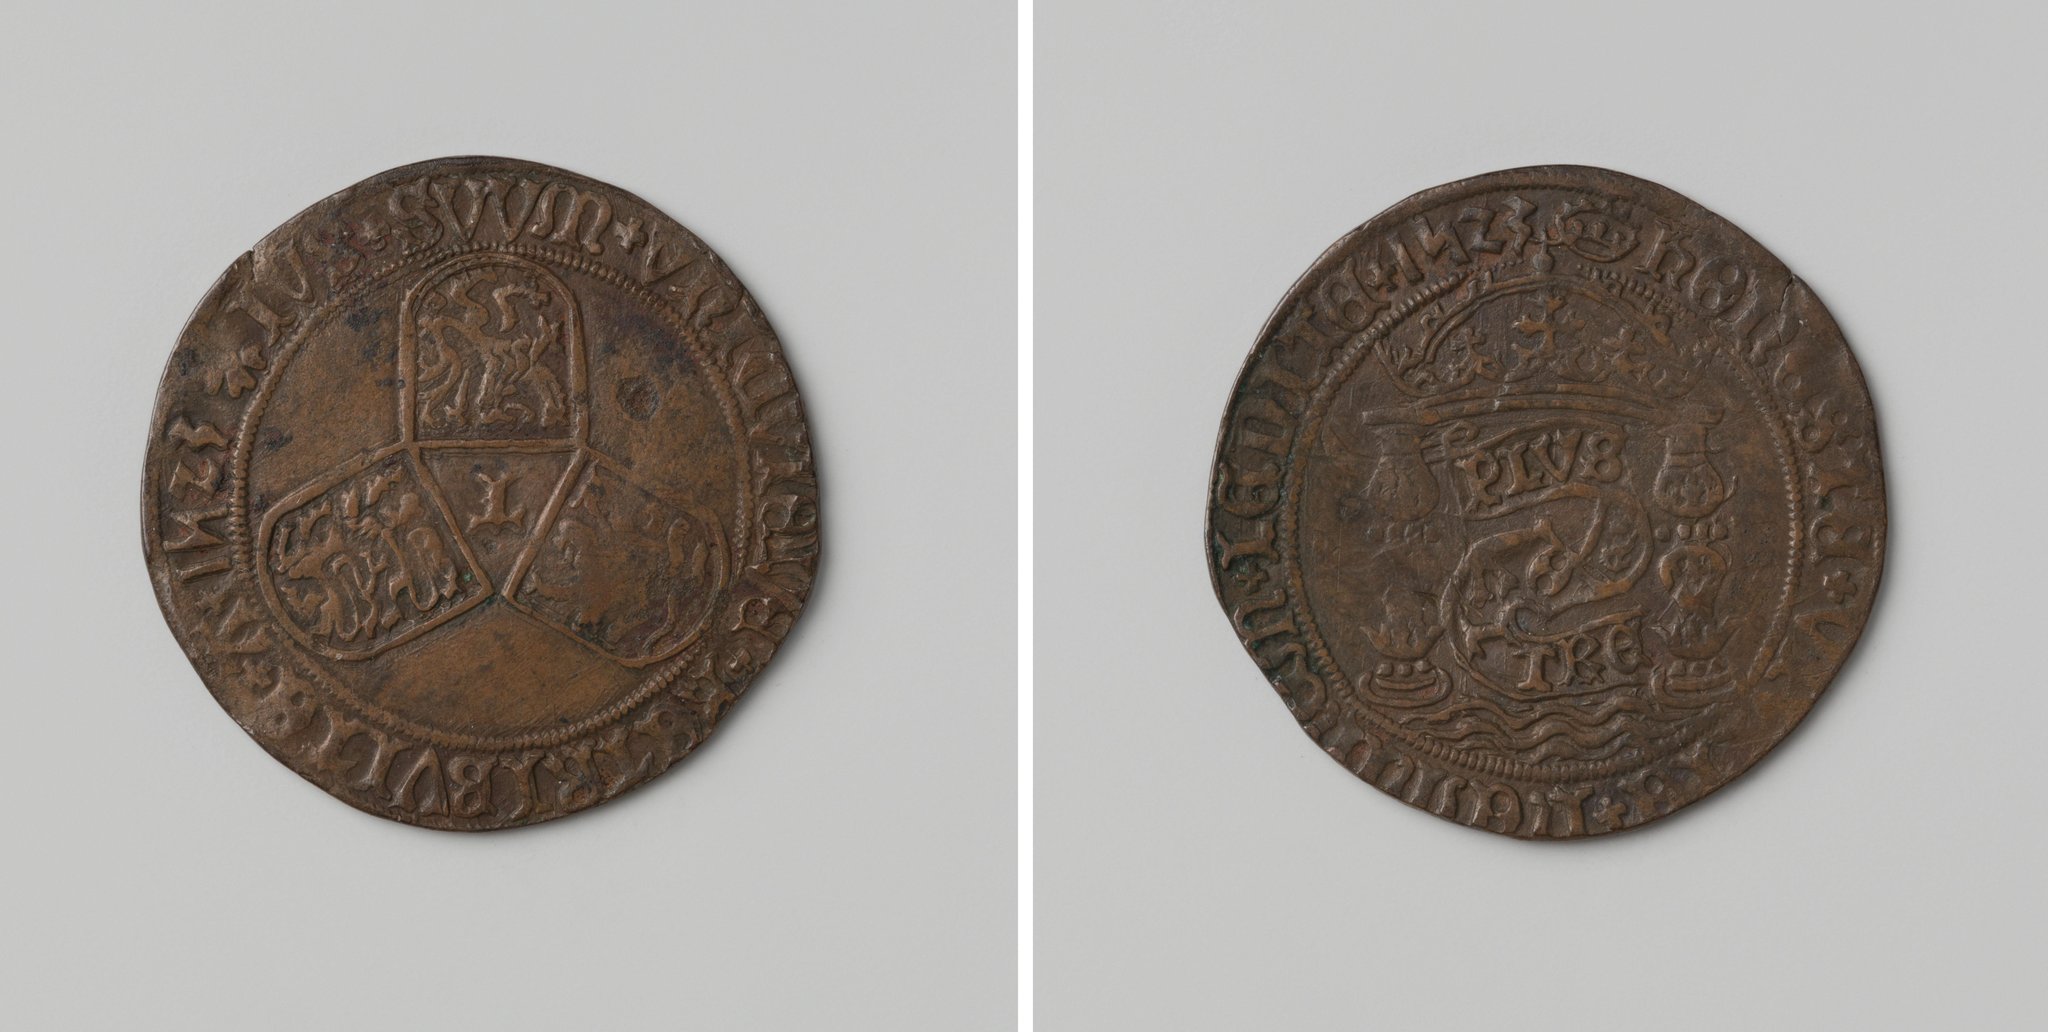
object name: jeton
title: Voorbereidingen op de oorlog tegen Frankrijk, rekenpenning van Holland, Zeeland en Friesland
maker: Anonymous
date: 1523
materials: copper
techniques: striking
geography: netherlands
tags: ghent, charles v (holy roman emperor and king of spain), zeeland, holland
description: Koperen penning. Voorzijde: drie wapenschilden in kring geplaatst rond letter L binnen omschrift. Keerzijde: wimpel met opschrift tussen zuilen van Herkules onder kroon binnen omschrift